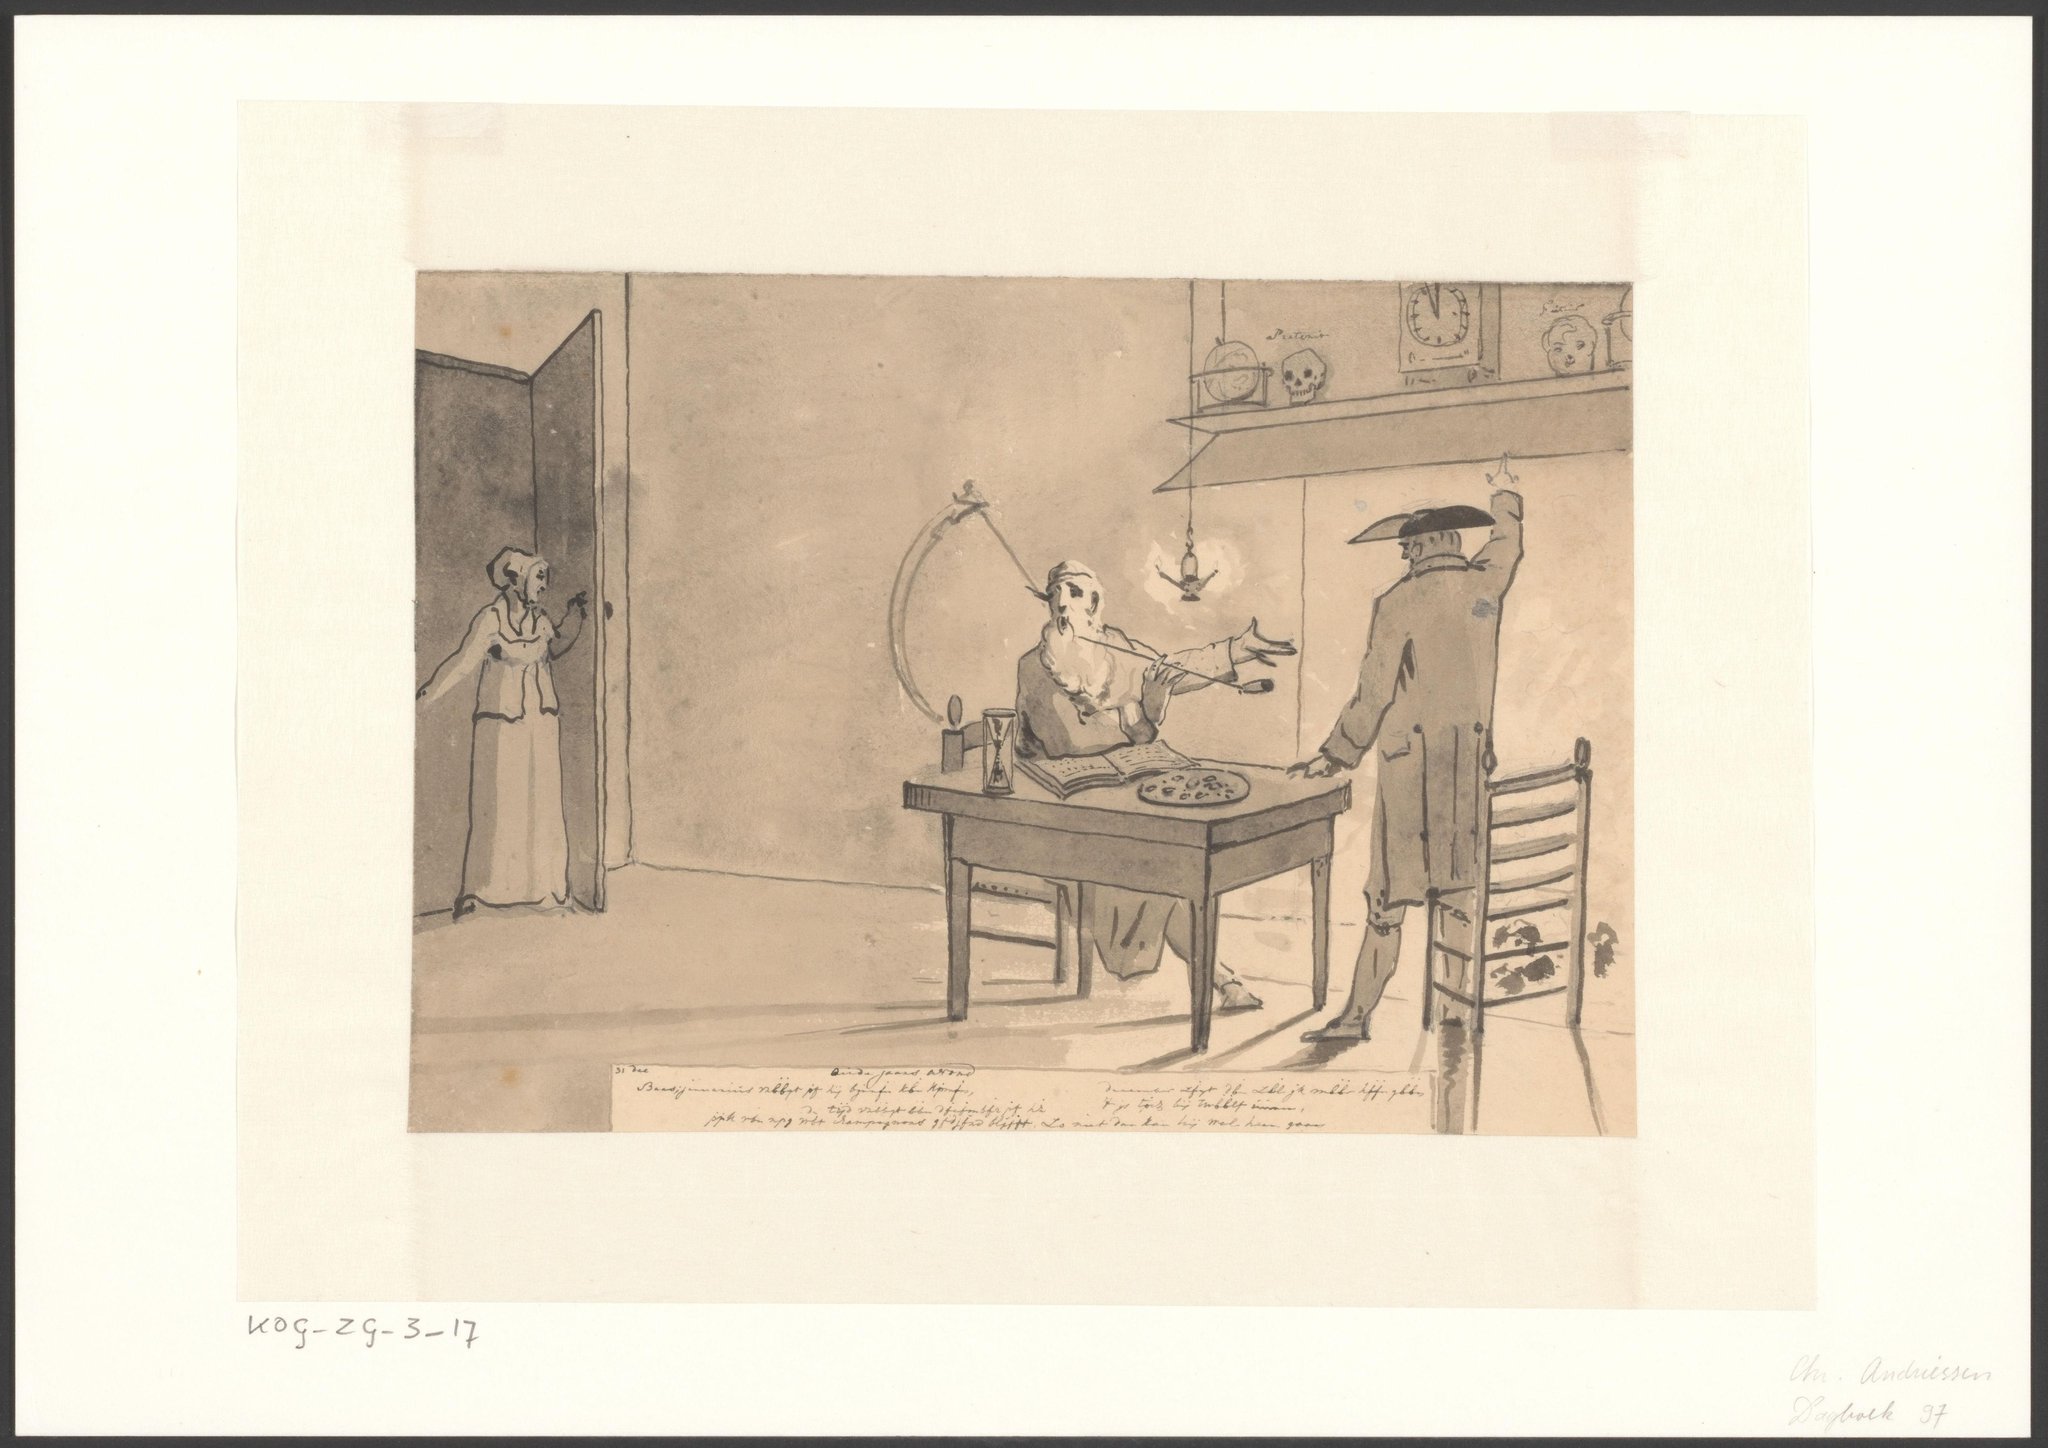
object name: drawing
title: Oudejaar zit aan een tafel en het nieuwe jaar wijst naar de klok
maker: christiaan andriessen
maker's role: draughtsman, print maker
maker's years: 1775-1846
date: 1804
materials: ink, paper, pencil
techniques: brush, pen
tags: new year's eve (december 31), interior of the house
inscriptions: inscription: ‘Oudejaarsavond (...)’, inscription: ‘J Andriessen’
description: Dagboekblad uit het getekende dagboek dat Christiaan Andriessen bijhield van 1805 tot en met 1808.